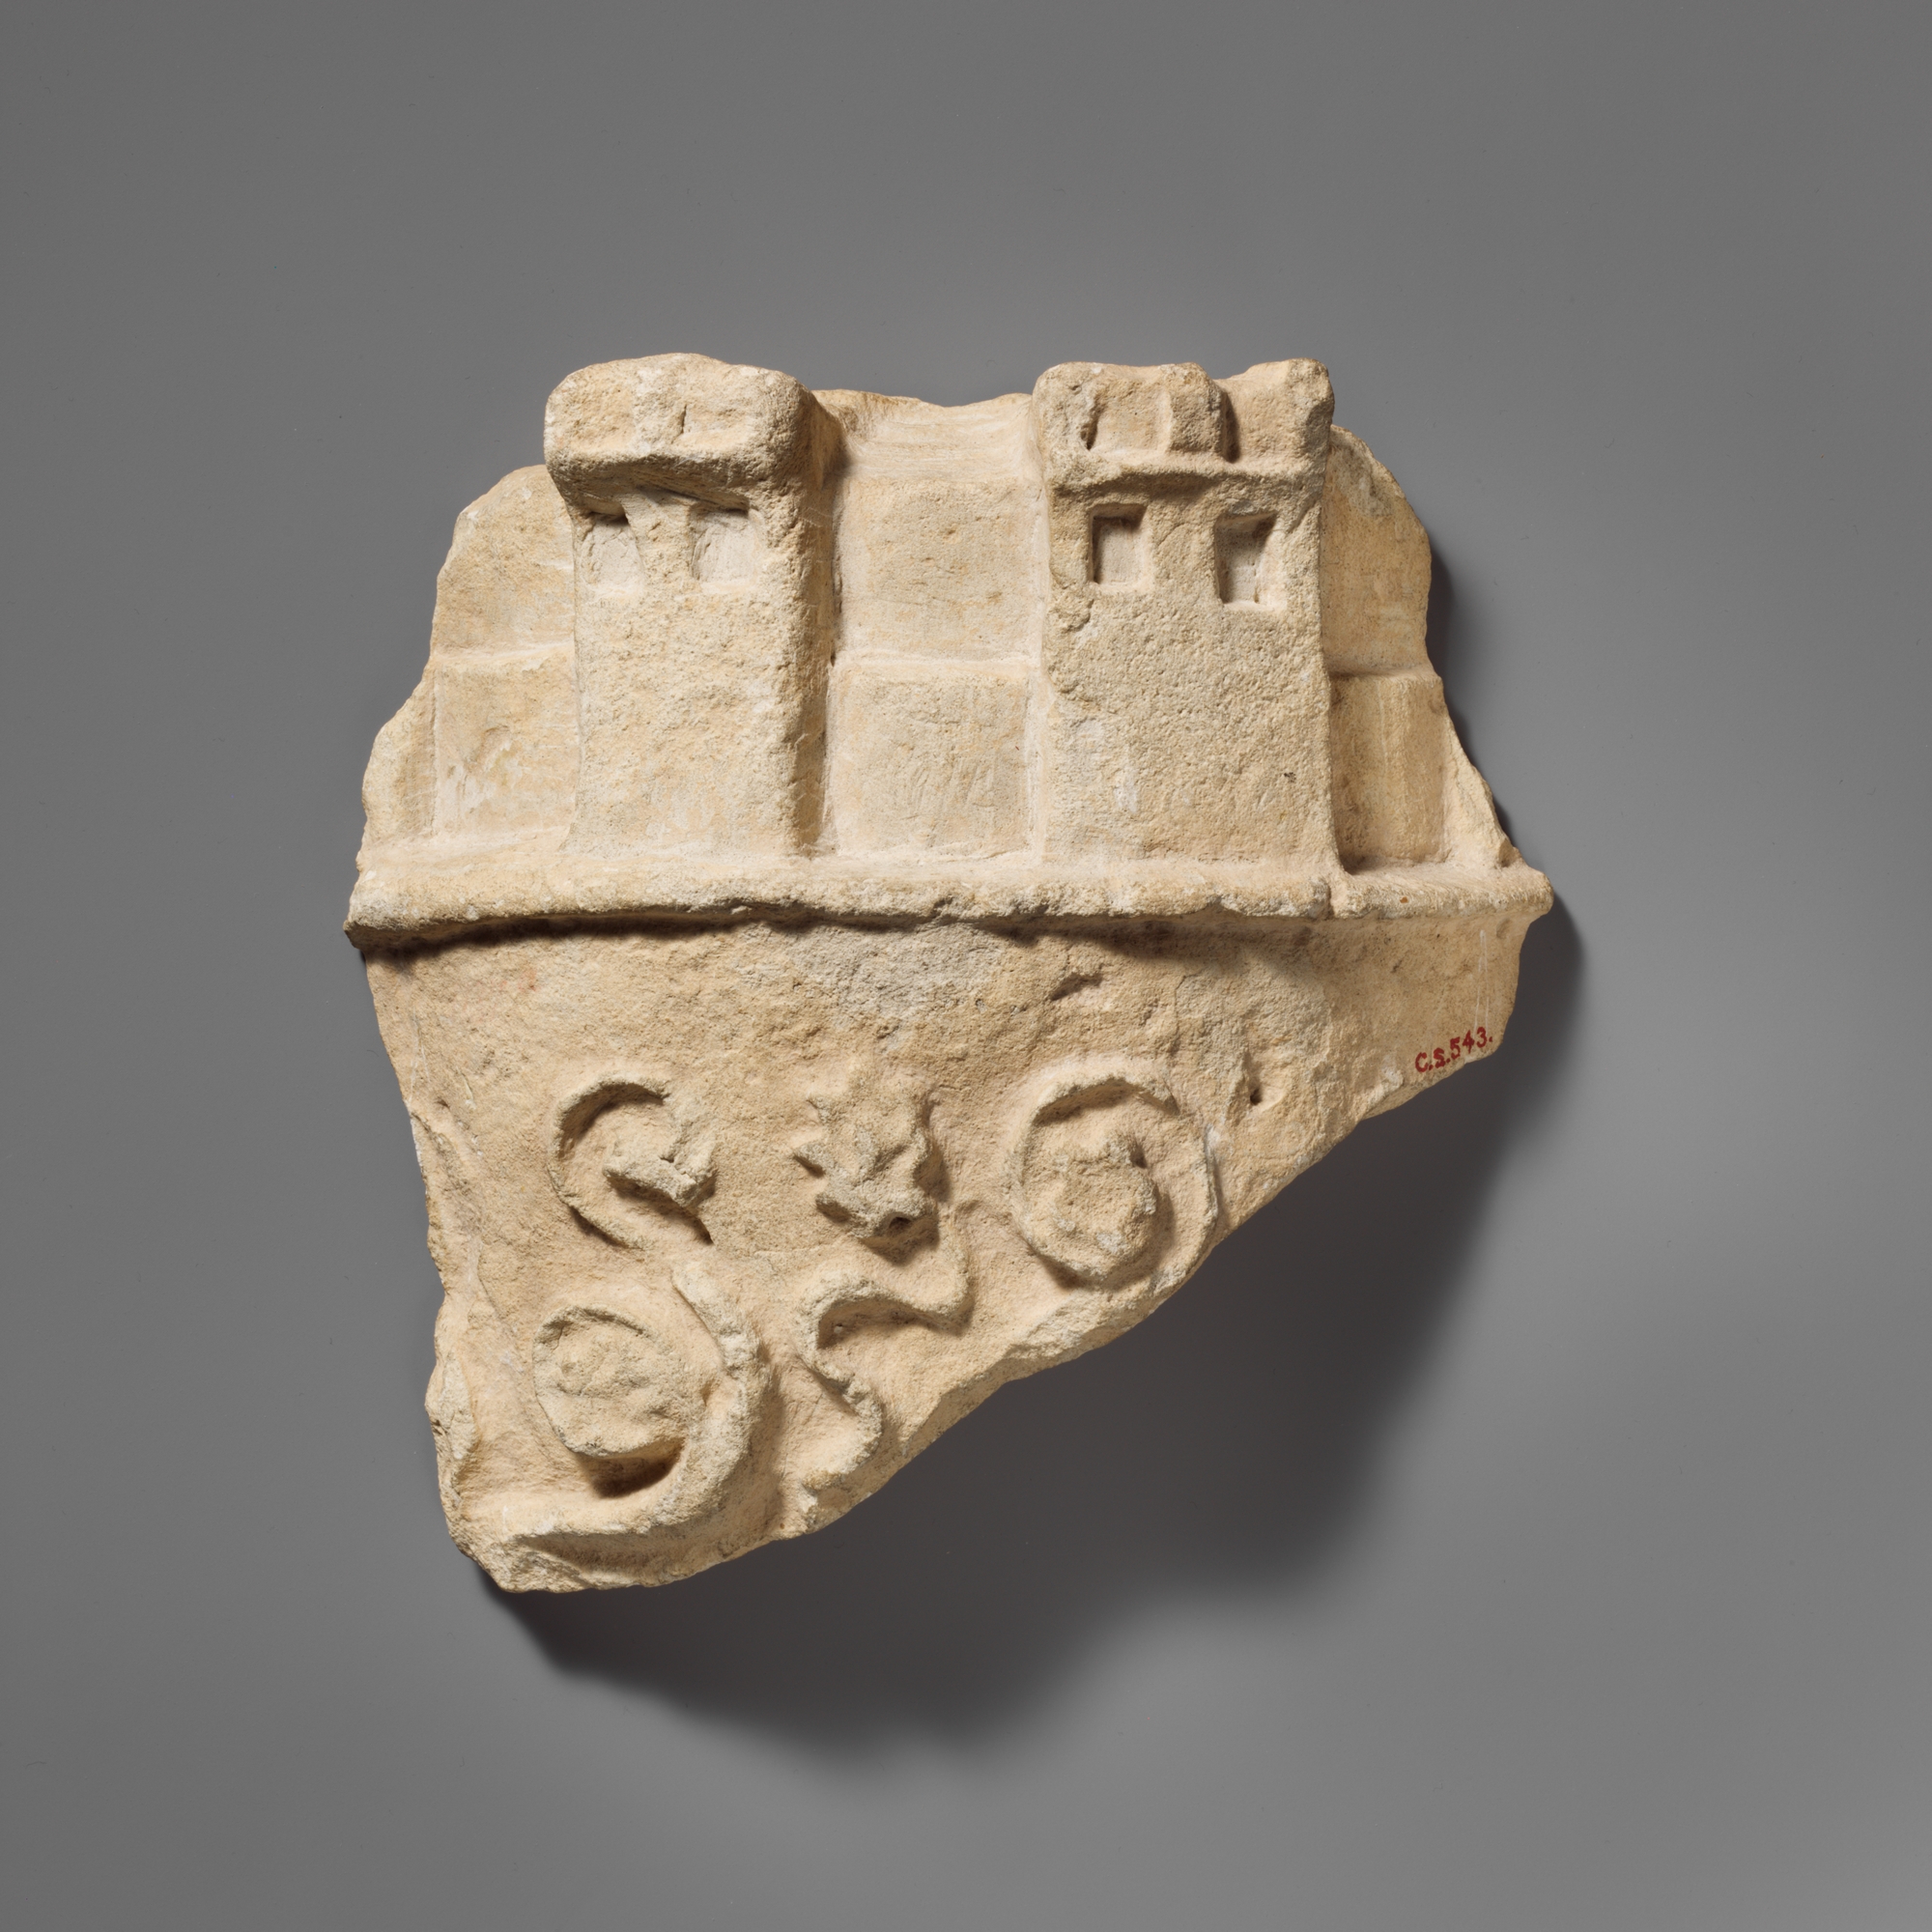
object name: statue fragment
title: Fragment of a limestone crown belonging to a statue of the Great Goddess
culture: cypriot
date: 350-301 BCE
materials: limestone